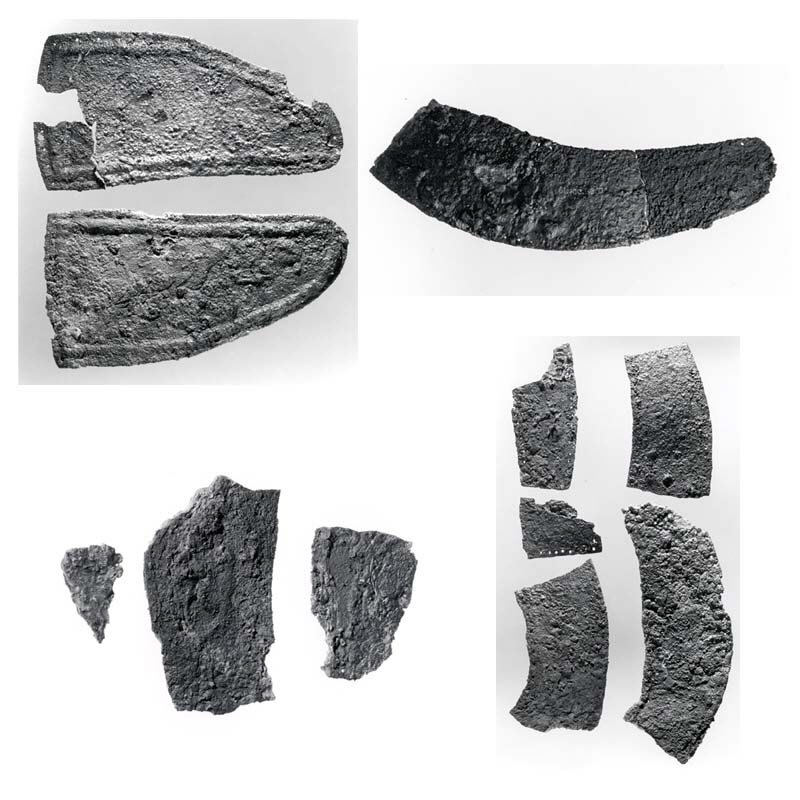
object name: helmet fragment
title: Crested helmet fragments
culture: iranian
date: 900-801 BCE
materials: bronze, copper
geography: iran